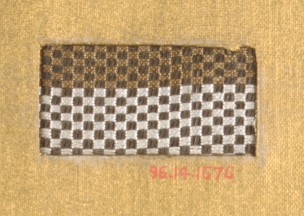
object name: piece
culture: japanese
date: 1701-1900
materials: silk